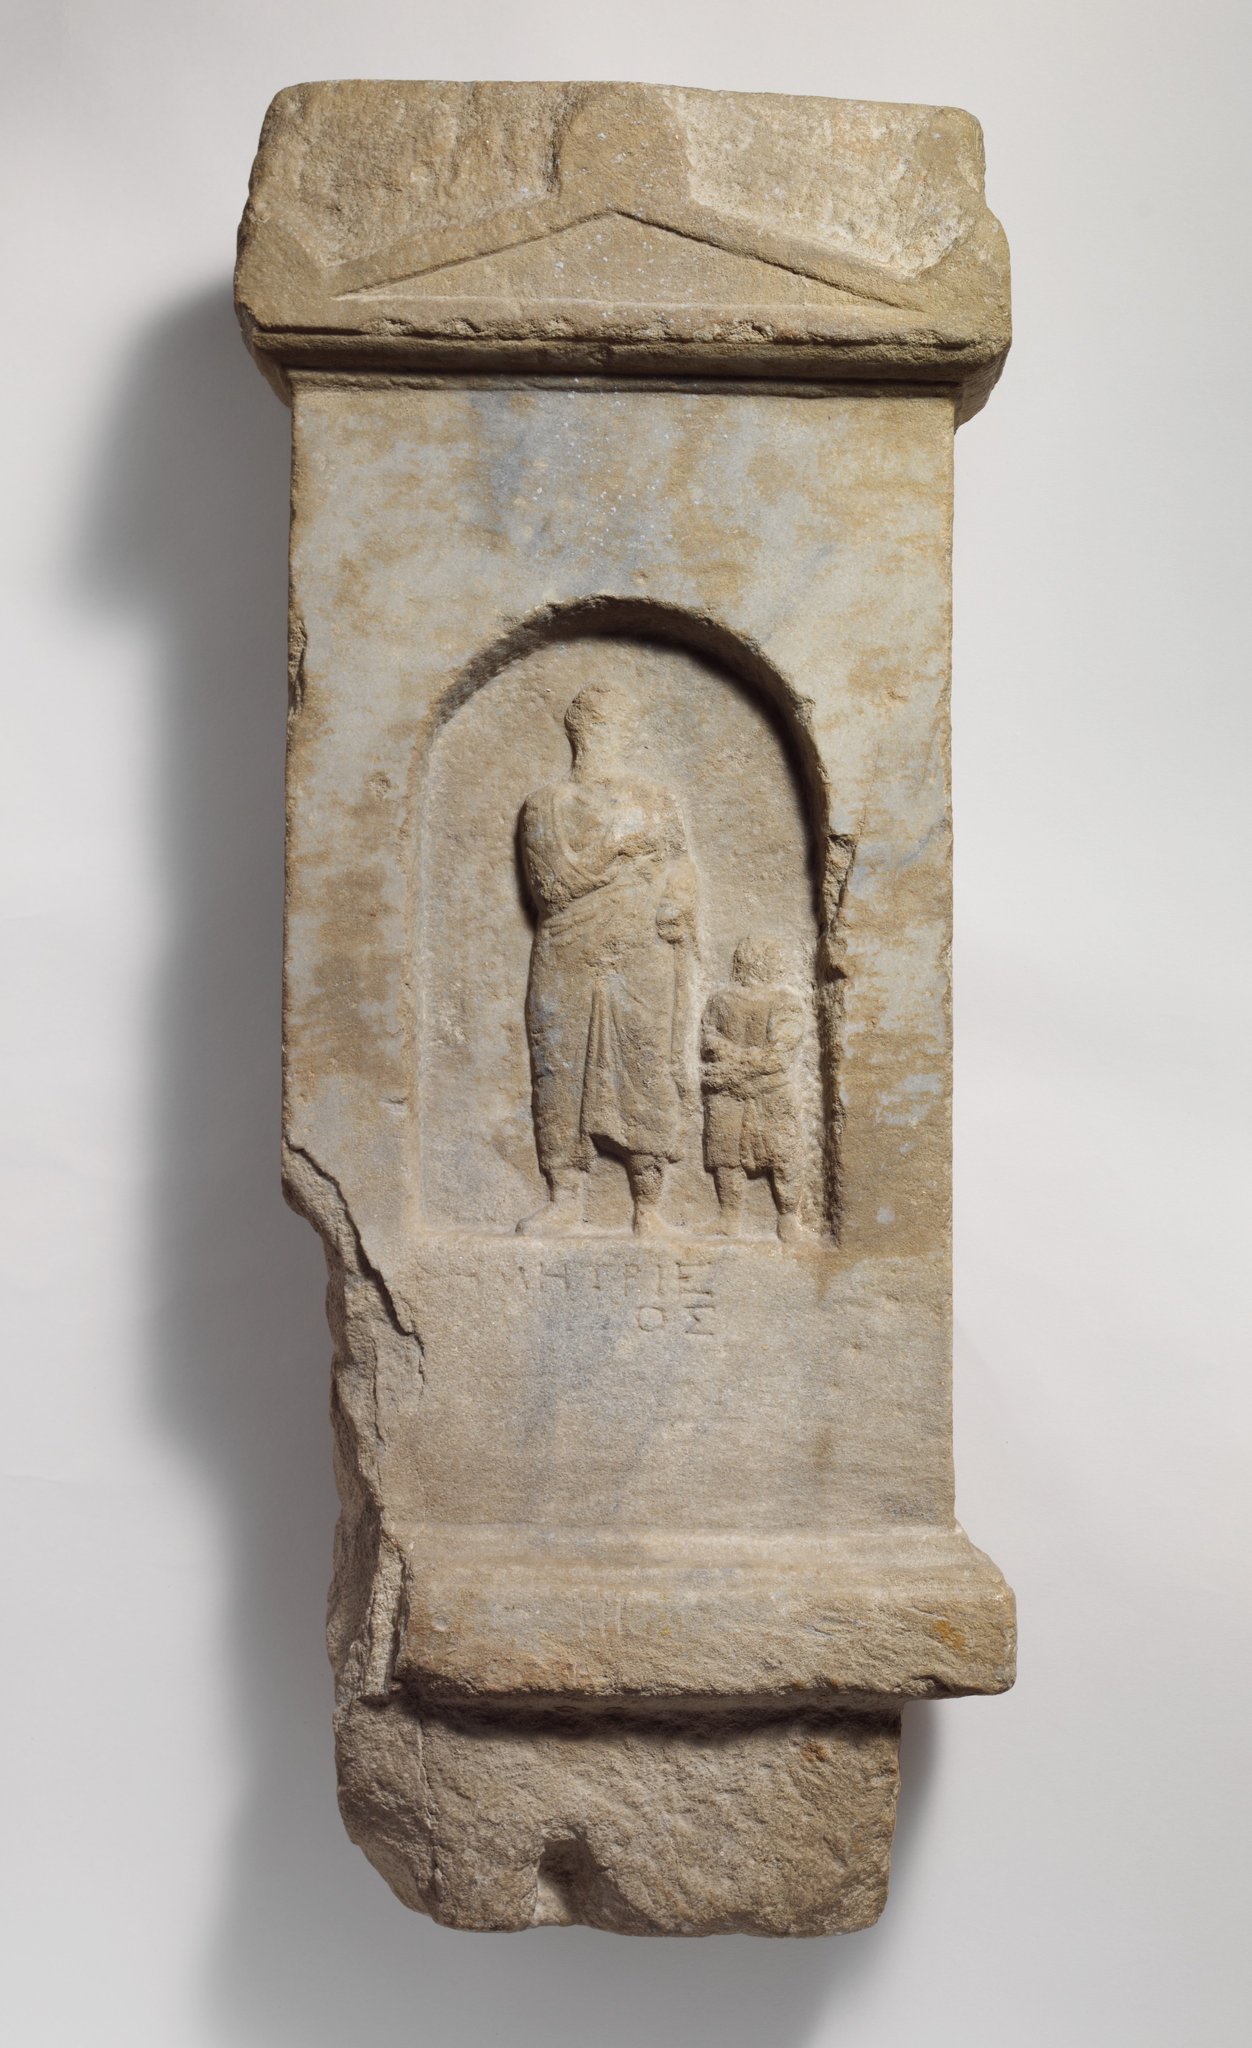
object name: grave stele of demetrios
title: Marble grave stele of Demetrios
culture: greek, cypriot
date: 100-1 BCE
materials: marble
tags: children,men